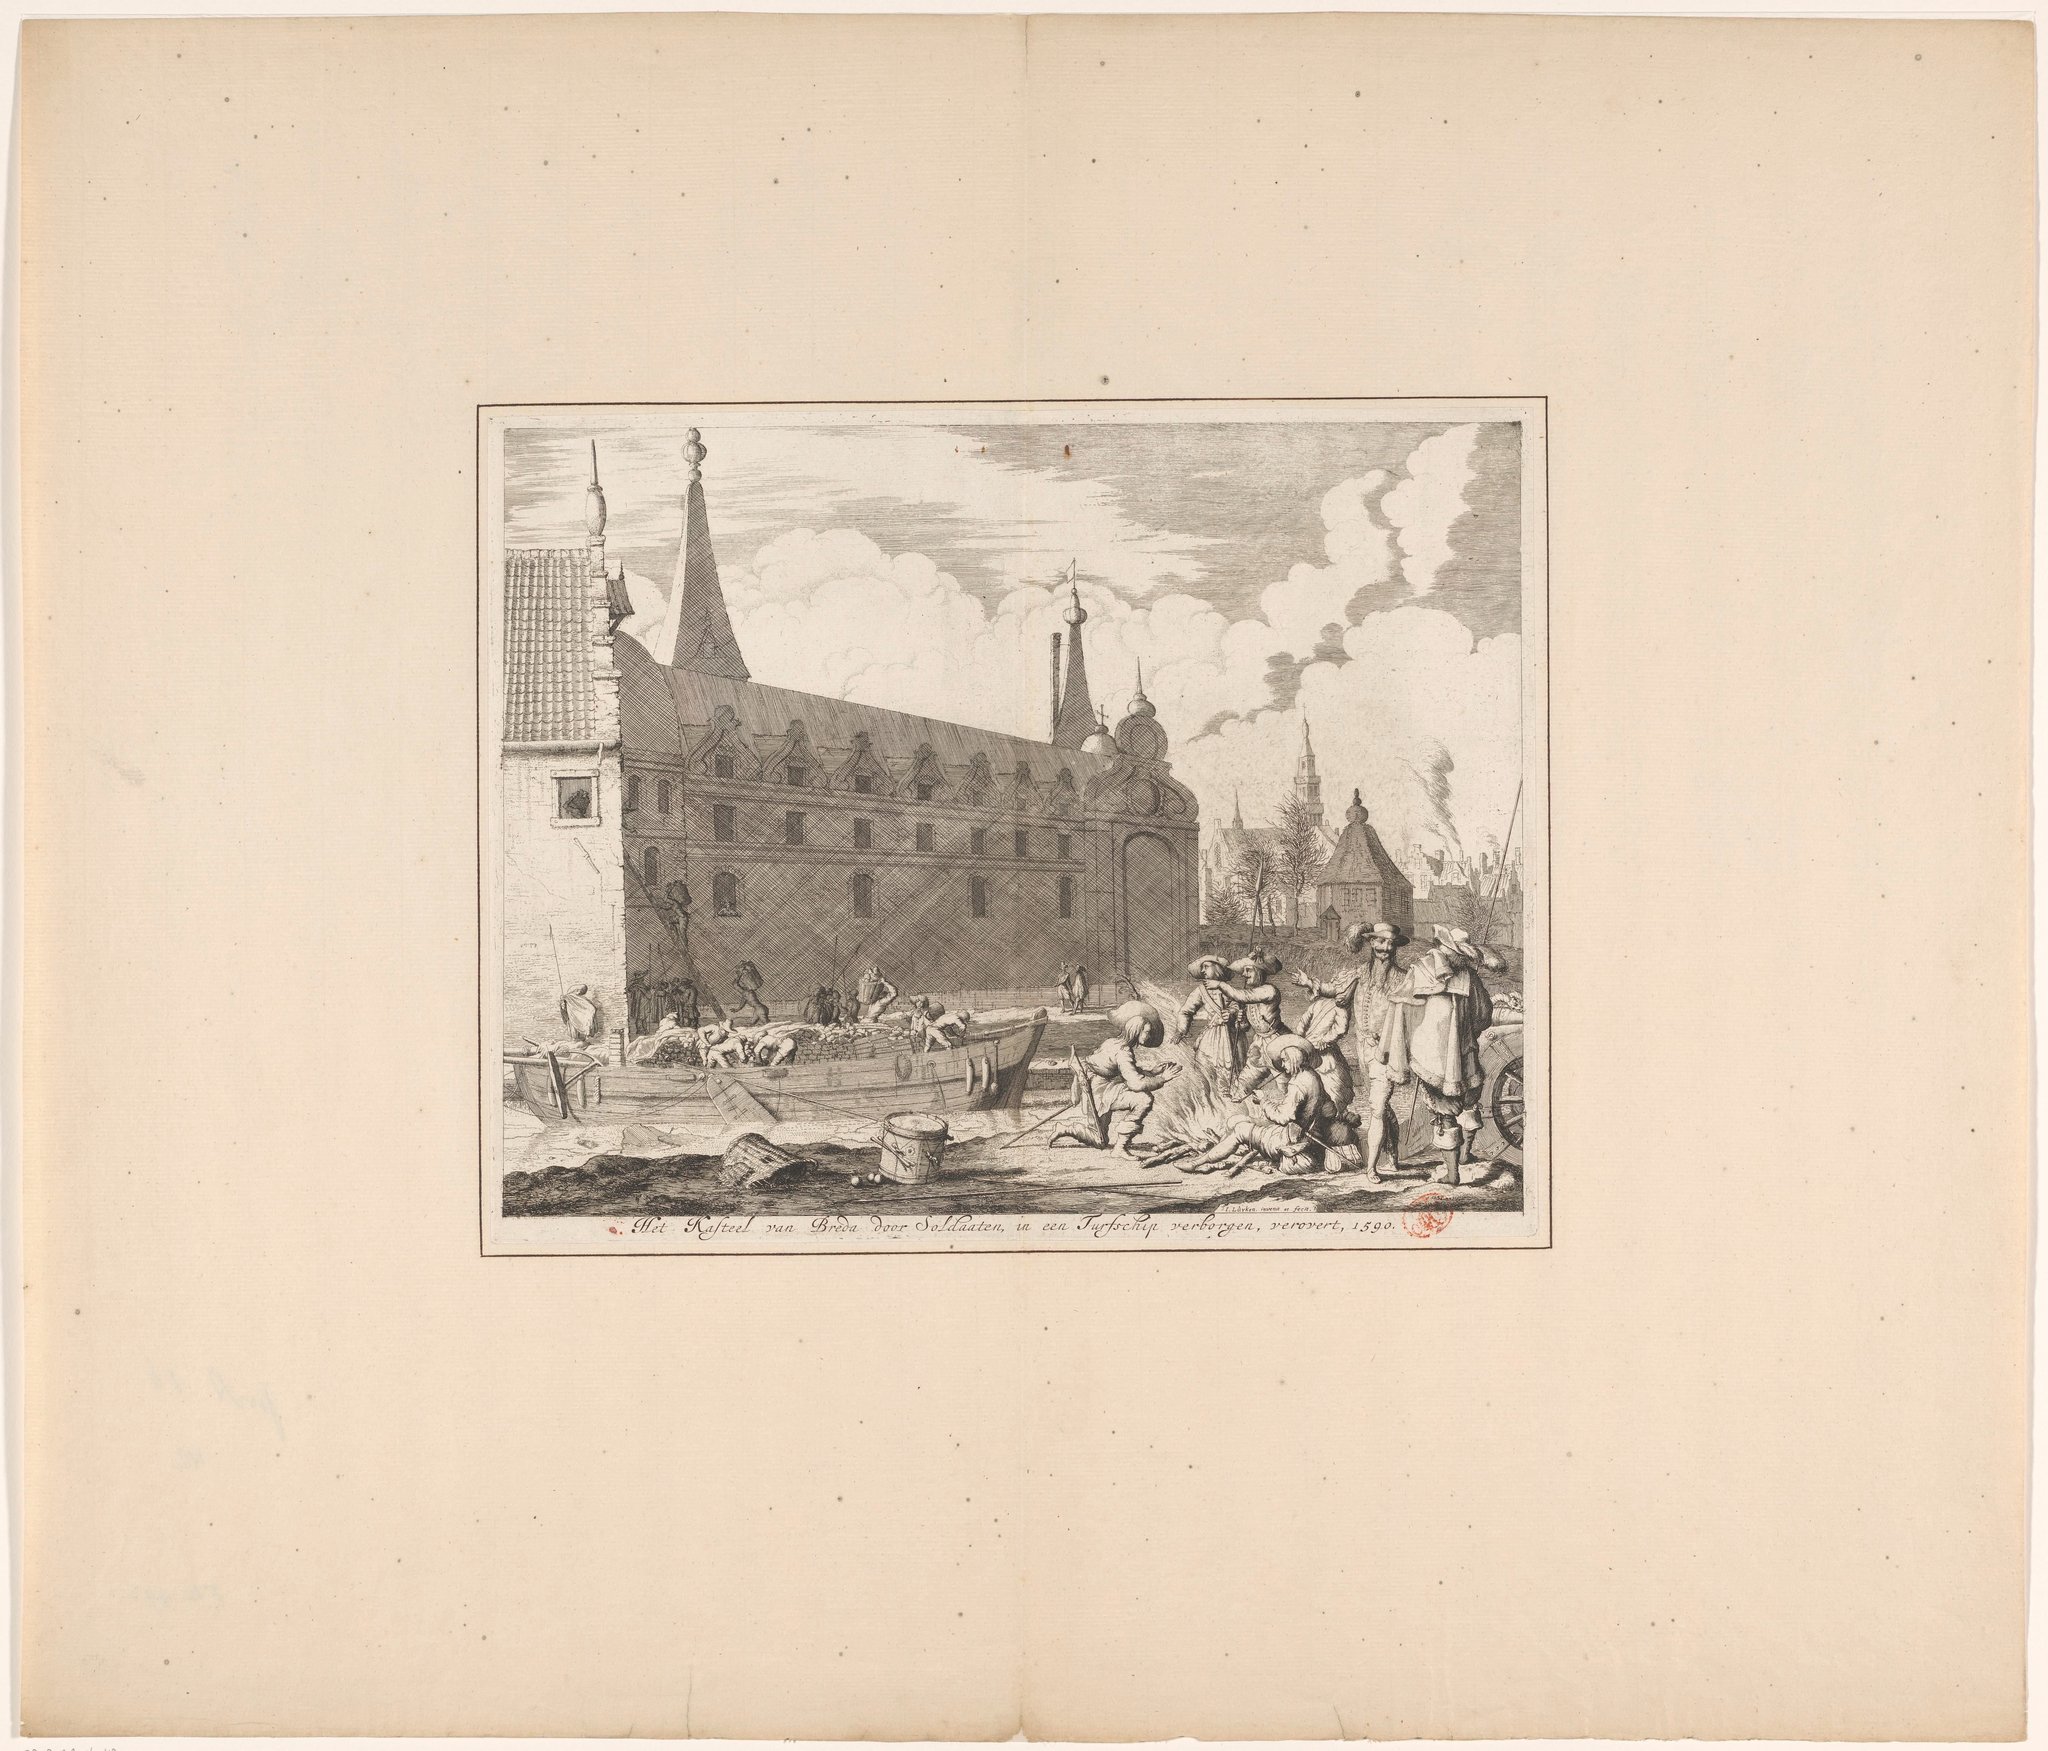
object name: print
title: De list met het Turfschip van Breda, 1590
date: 1681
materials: paper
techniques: engraving, etching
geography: amsterdam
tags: castle, the soldier off duty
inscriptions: collector's mark: Lugt 195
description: Huidige staat van prent ook gebruikt in: Bor Christiaansz, Pieter. Oorsprongk, begin, en vervolgh der Nederlandsche oorlogen (…), 4 delen. Amsterdam: weduwe Joannes van Someren, Abraham Wolfgang en Hendrick en Dirk Boom, 1679-1684, dl. 3 (1681), p. 522-523. En in: Groot, Hugo de. Nederlandtsche Jaerboeken en Historien. Amsterdam: weduwe Joannes van Someren, Abraham Wolfgang en Hendrick en Dirk Boom, 1681, p. 152.